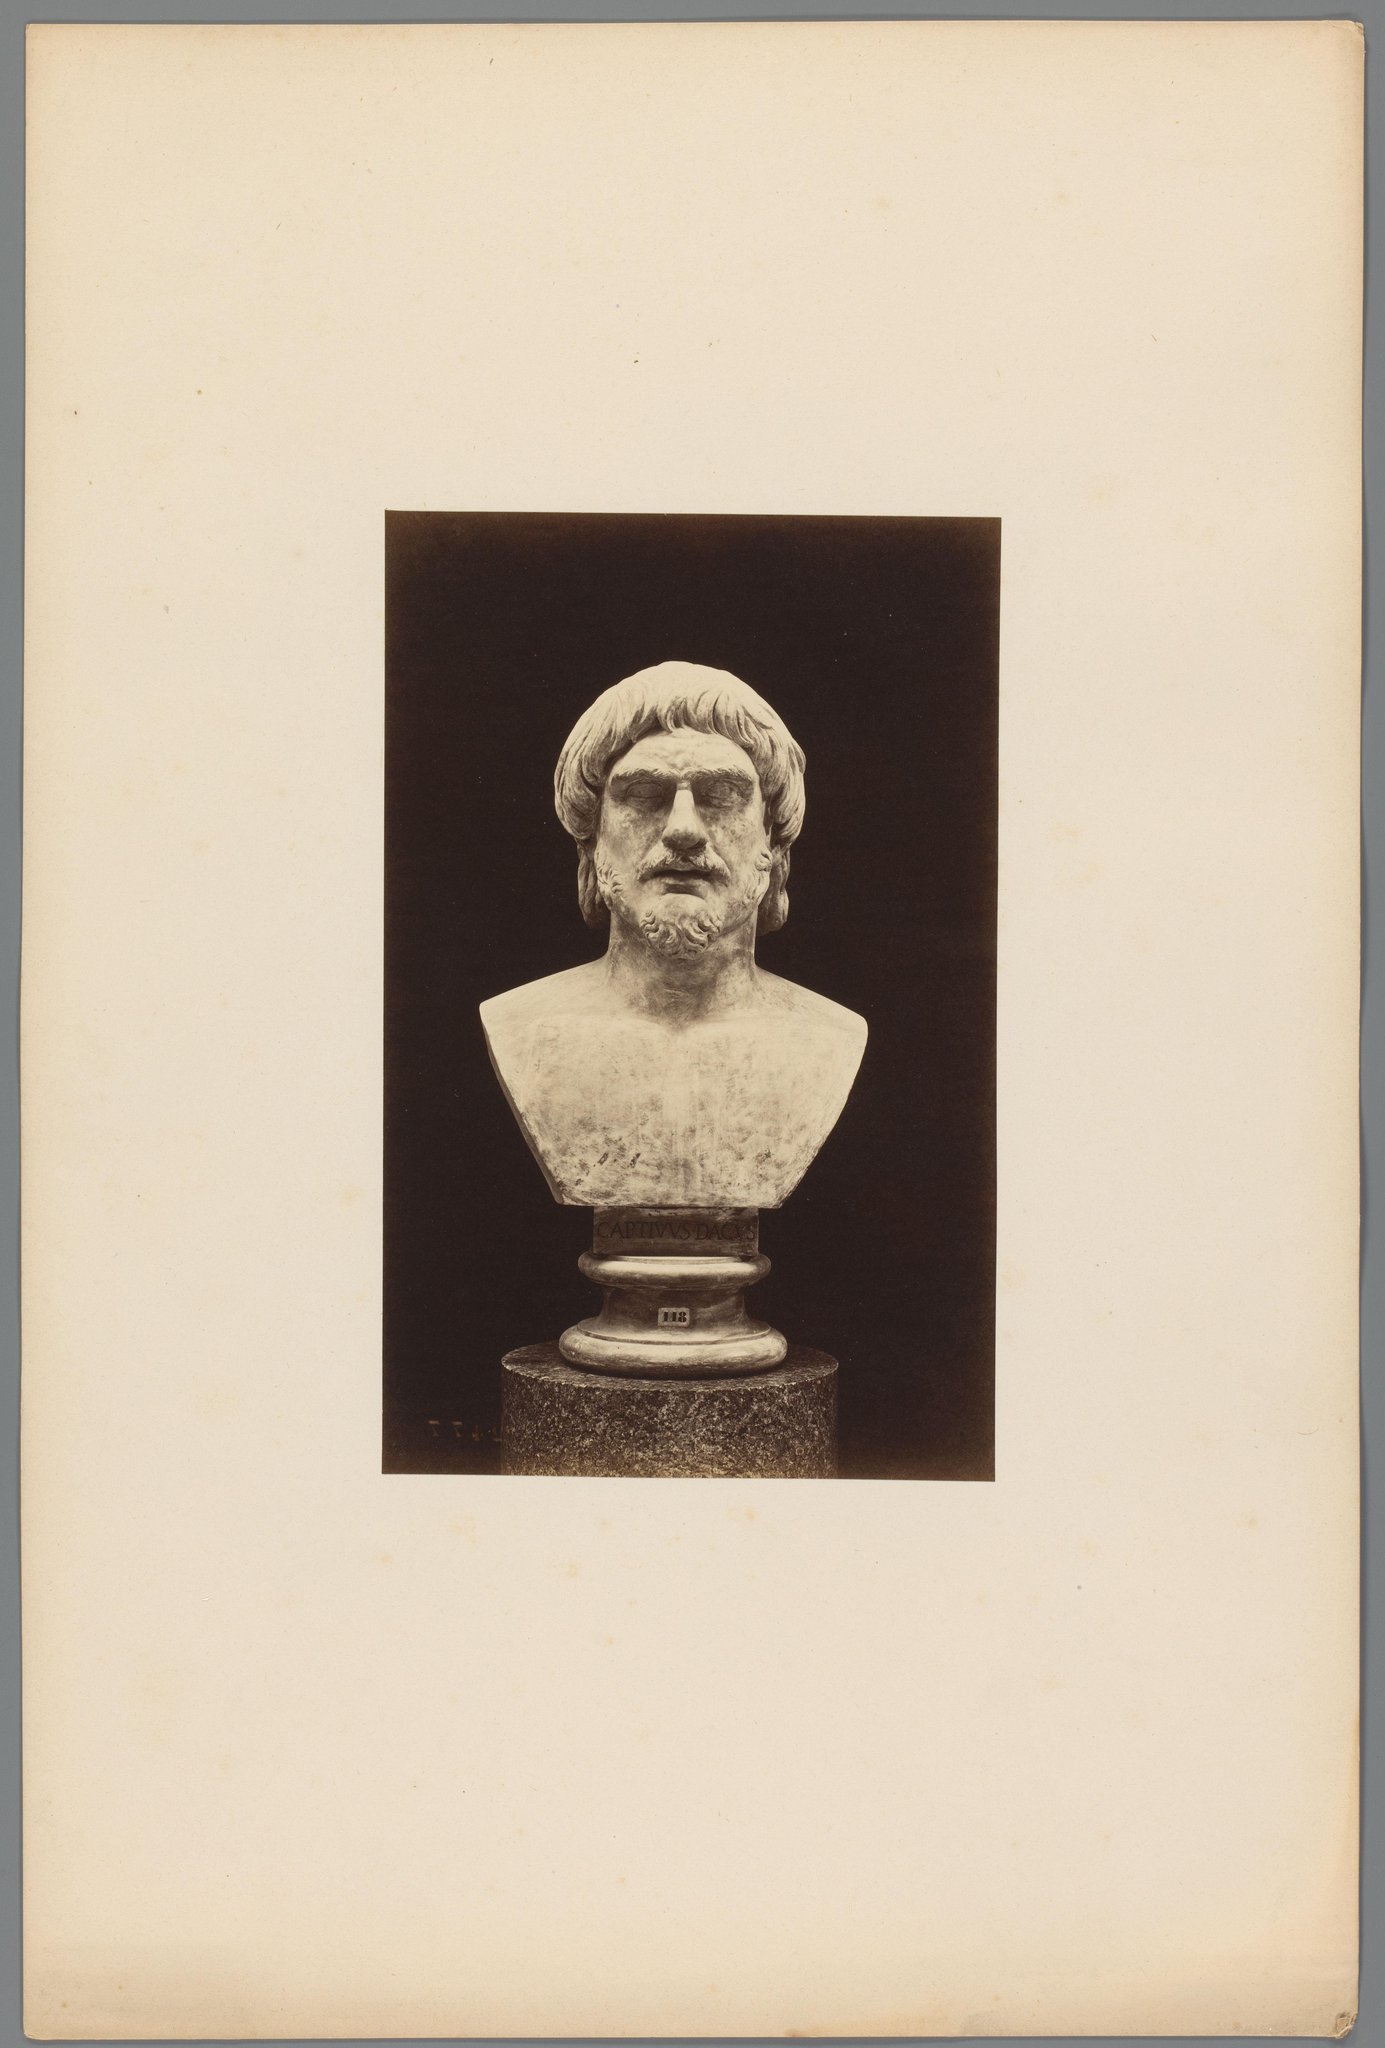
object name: photograph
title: Buste van een man met baard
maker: Anonymous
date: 1851-1900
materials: cardboard, paper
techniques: albumen print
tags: head (human), piece of sculpture, reproduction of a piece of sculpture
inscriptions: number: ‘2477 [?]’